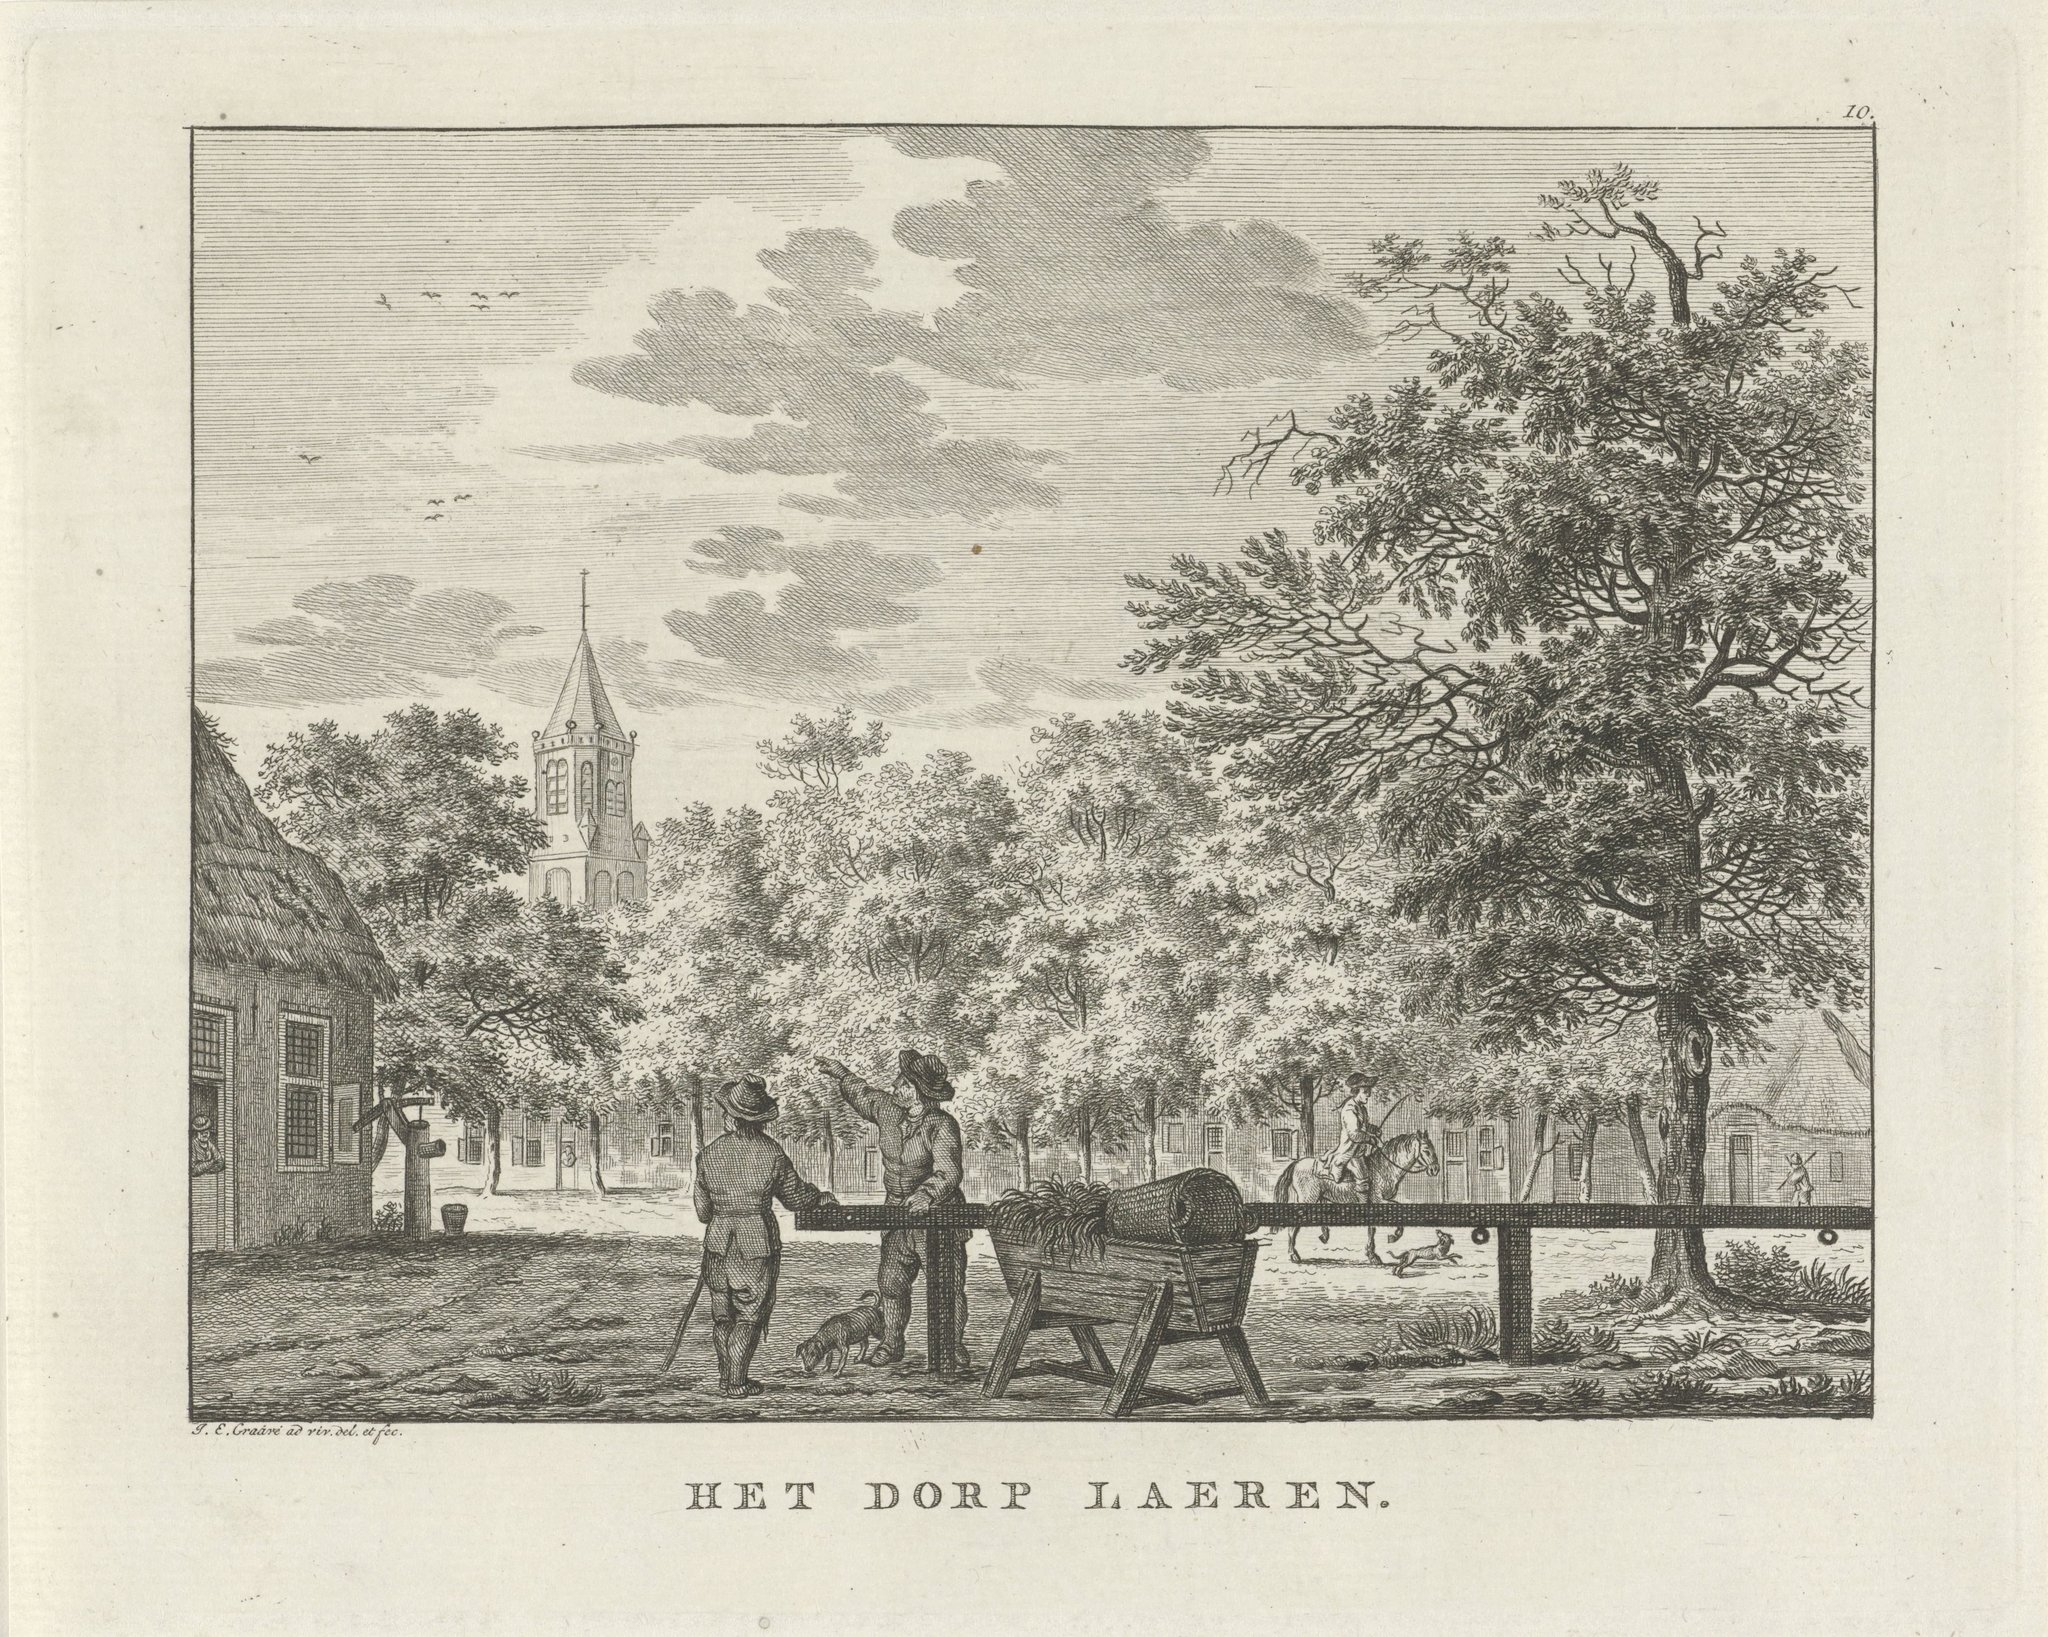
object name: print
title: Nederlandse dorpen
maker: jan evert grave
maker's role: draughtsman, print maker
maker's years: 1759-1805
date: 1786-1805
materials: paper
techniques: engraving, etching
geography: amsterdam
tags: village square, place (+ city(-scape) with figures, staffage)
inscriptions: collector's mark: Lugt 2228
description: Het dorp Laren. Op de voorgrond het dorpsplein. Op de achtergrond de kerktoren. De prent maakt deel uit van een serie met Nederlandse dorpen.